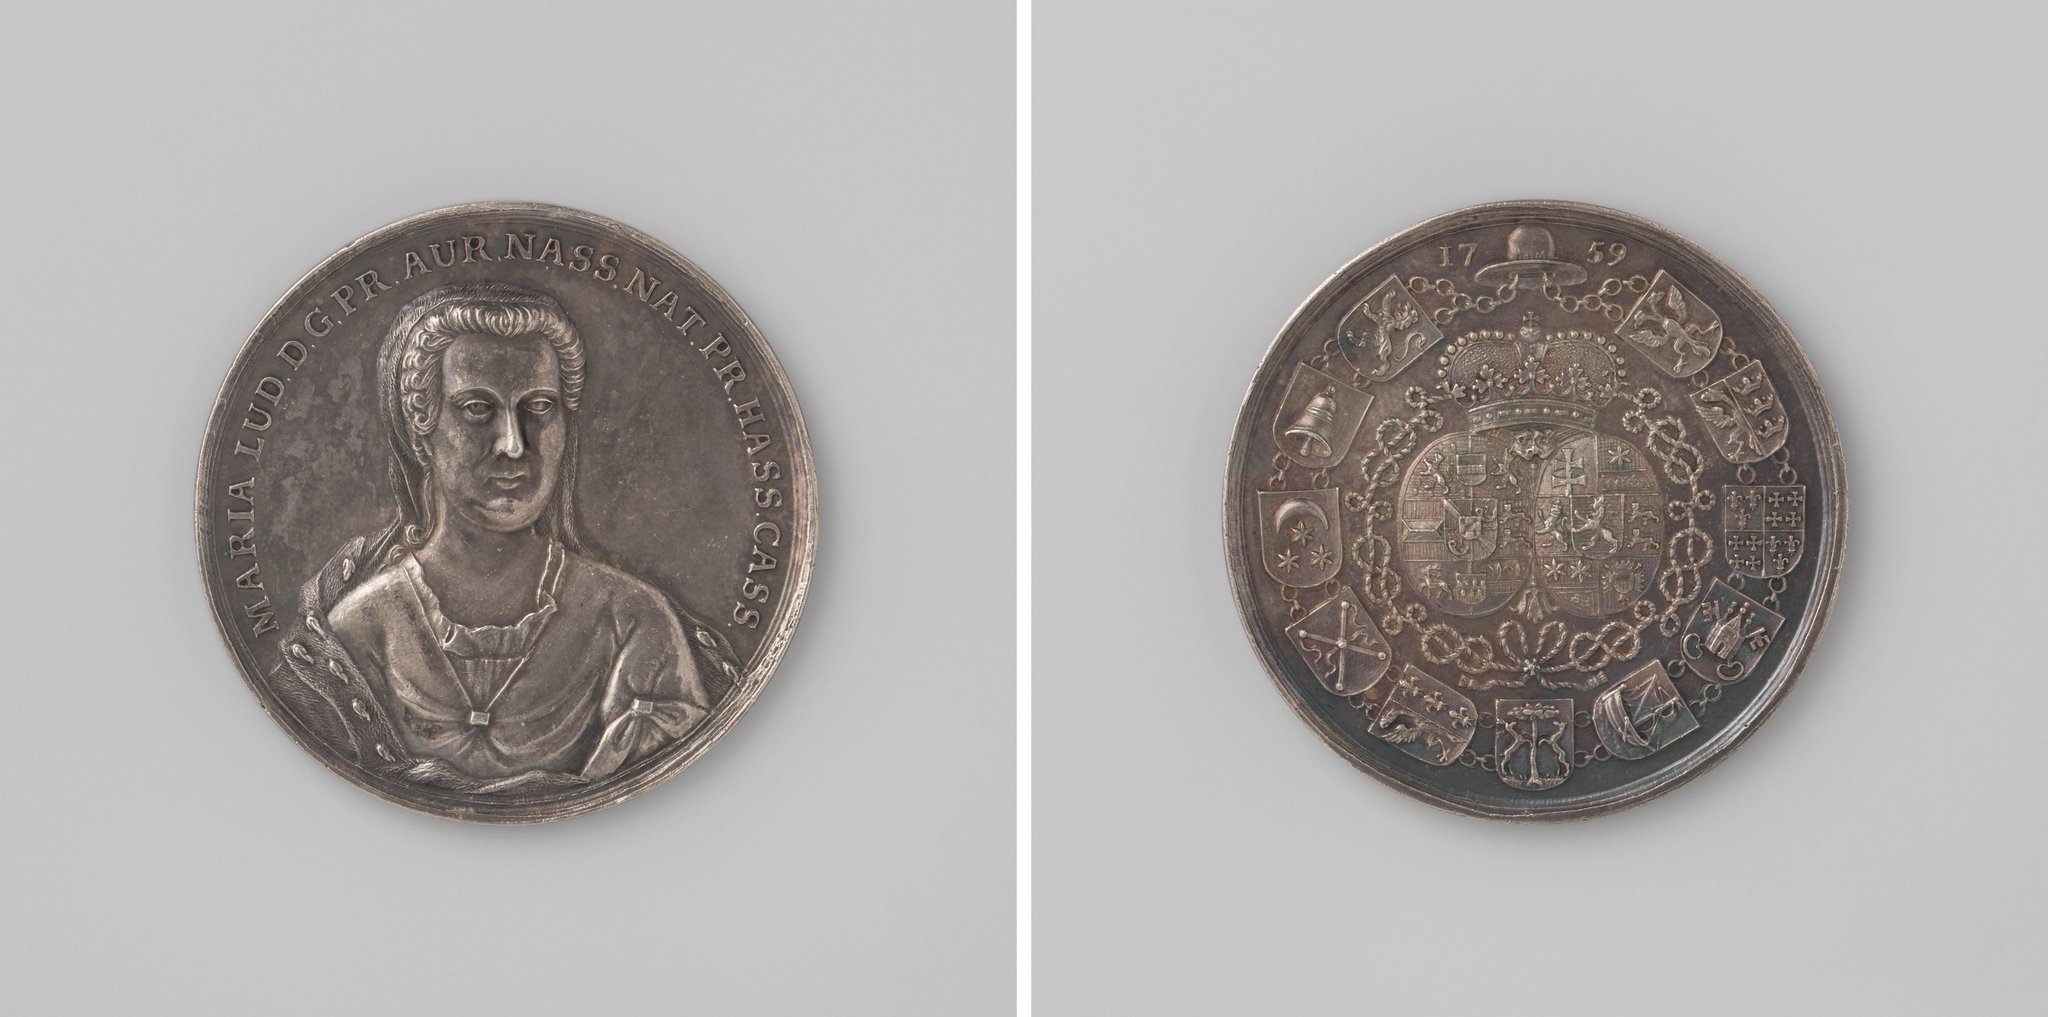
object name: landdagpenning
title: Maria Louise, prinses van Oranje-Nassau, penning haar aangeboden door het kwartier der Friese steden bij het ten tweede male aanvaarden van het stadhouderlijk bewind over Friesland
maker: nicolaas van swinderen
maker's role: jeweler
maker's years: 1705-1760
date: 1759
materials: silver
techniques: striking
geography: the hague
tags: kassel, leeuwarden, maria louisa van hessen-kassel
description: Zilveren penning. Voorzijde: borststuk vrouw met sluier binnen omschrift. Keerzijde: twee wapenschilden onder kroon, omringd door weduwesnoer binnen rand van elf met keten aan vrijheidshoed tussen jaartal gebonden wapenschilden